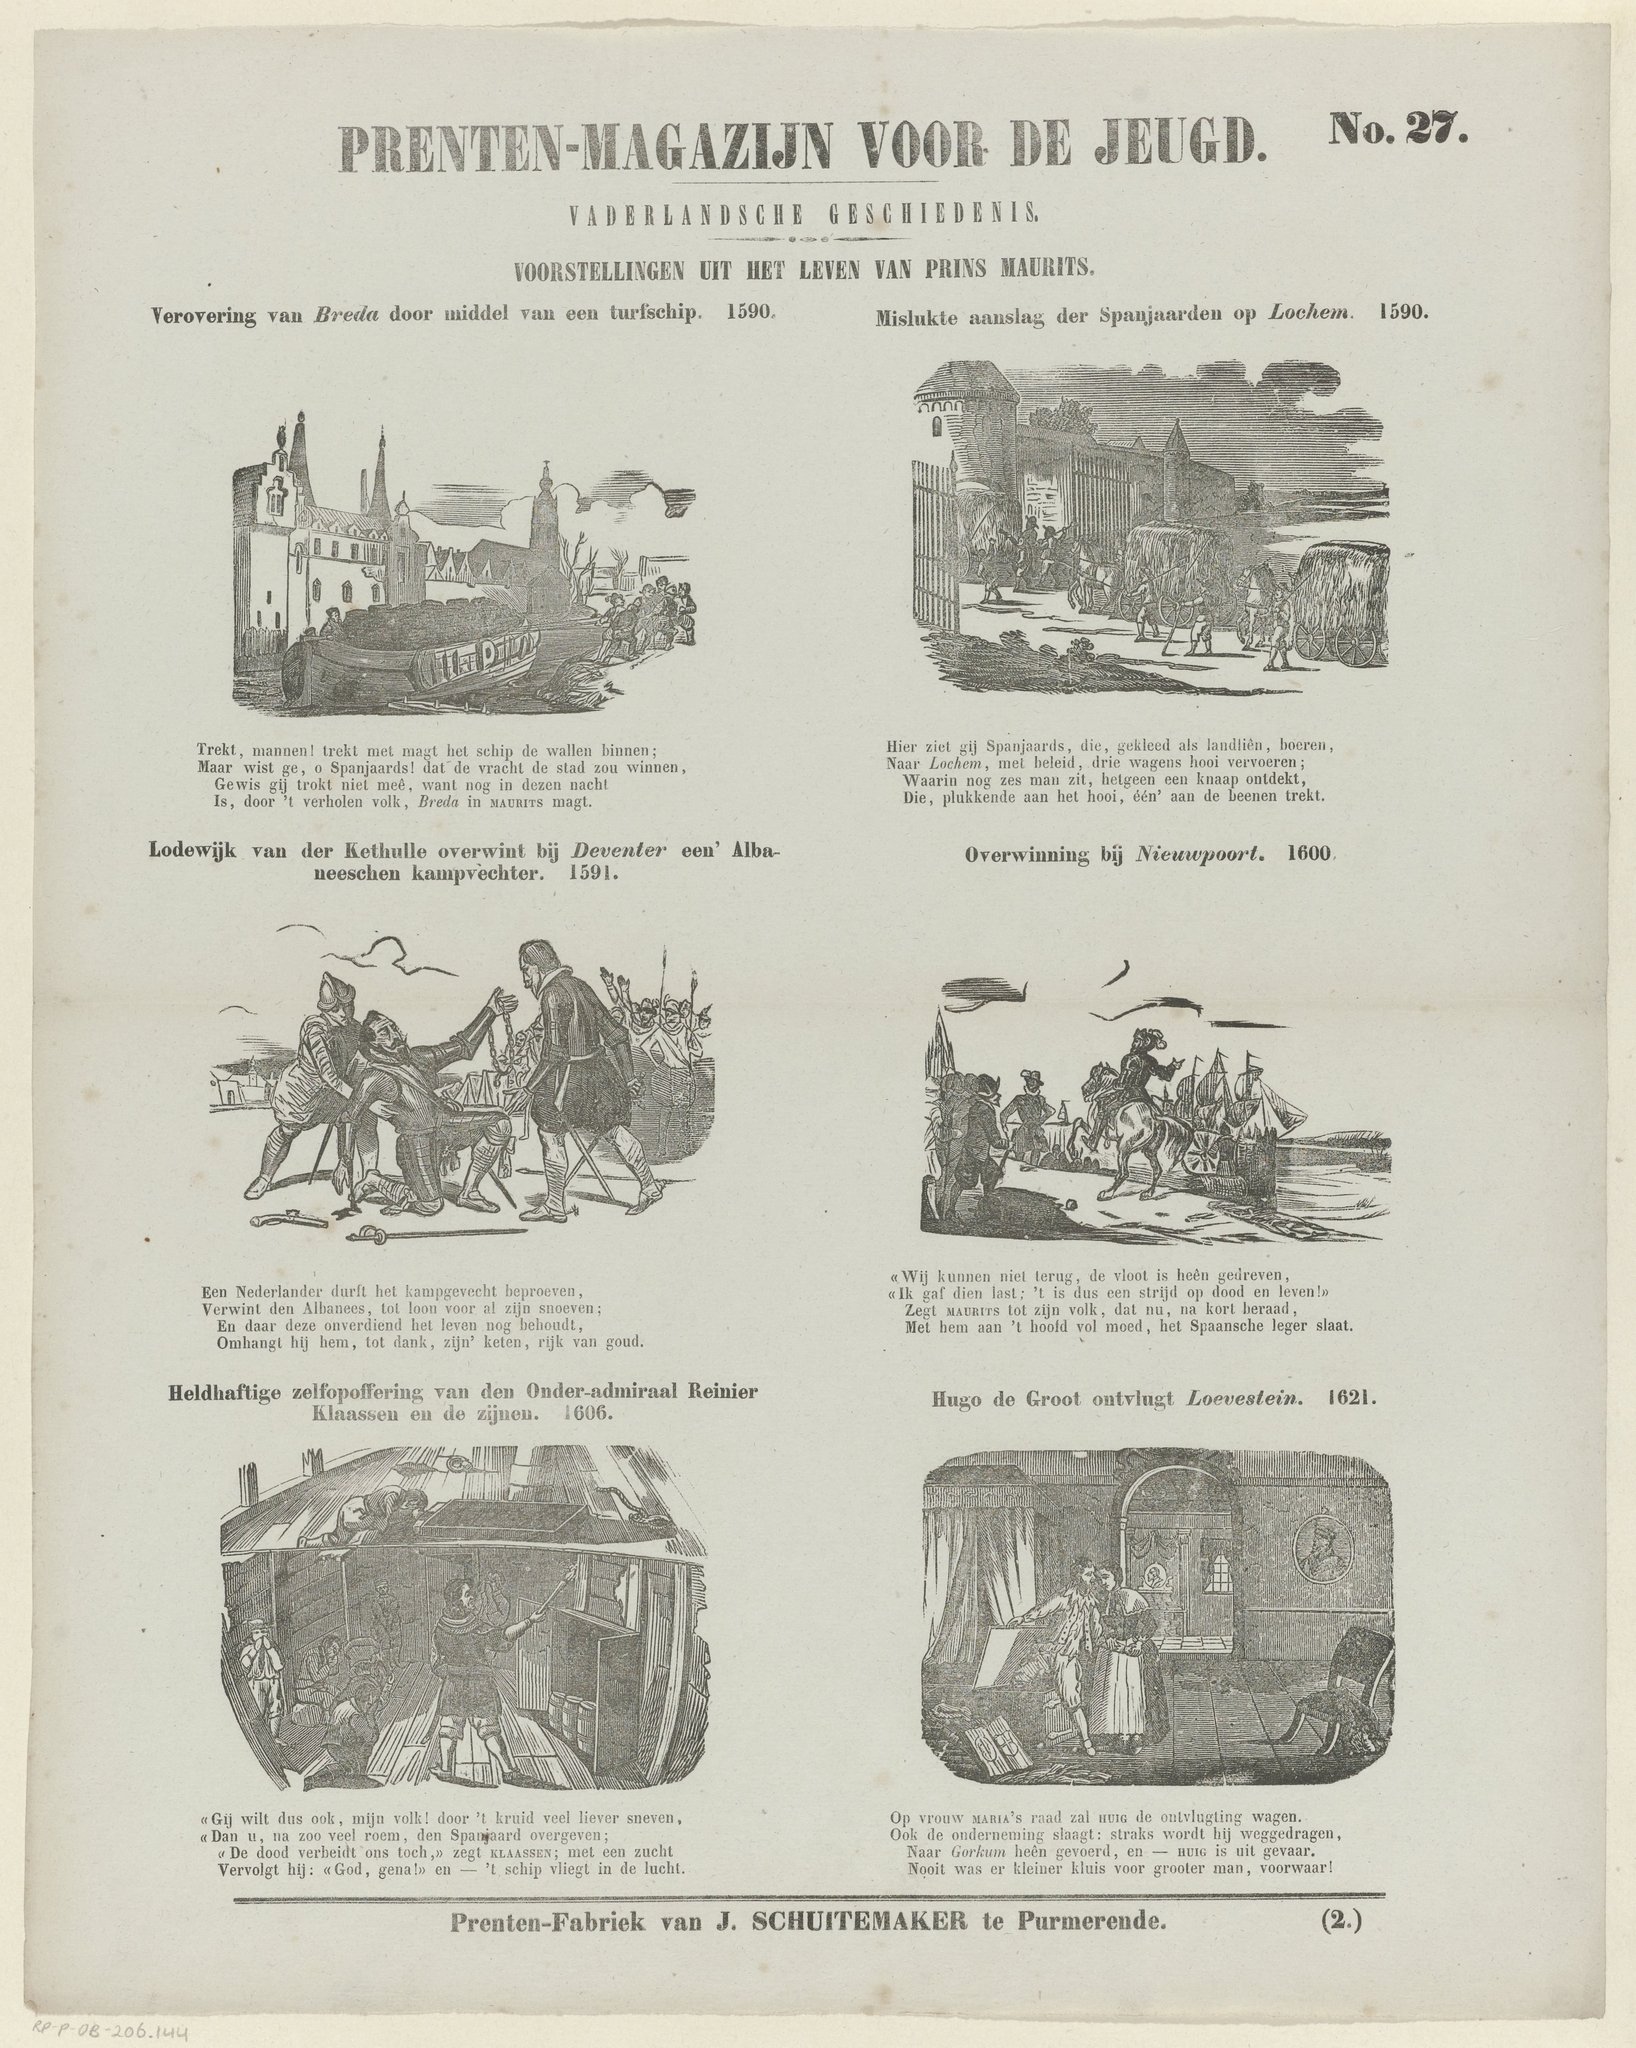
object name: print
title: Vaderlandsche geschiedenis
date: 1850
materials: paper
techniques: letterpress printing, engraving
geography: purmerend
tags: delft, hugo de groot, the hague, maurice (prince of orange), history, loevestein castle, deventer, battle of nieuwpoort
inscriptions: collector's mark: Lugt 2760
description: Na voltooiing van de acht jaargangen van de reeks 'Prenten-magazijn voor de jeugd' in 1850 heeft Jan Schuitemaker al deze prenten heruitgegeven en omgenummerd als nr. 1 t/m 192. De oorspronkelijke jaargang wordt telkens nog vermeld rechtsonder op de prent. Binnen de jaargangen zijn prenten van hetzelfde thema in clusters van vier achter elkaar gezet.